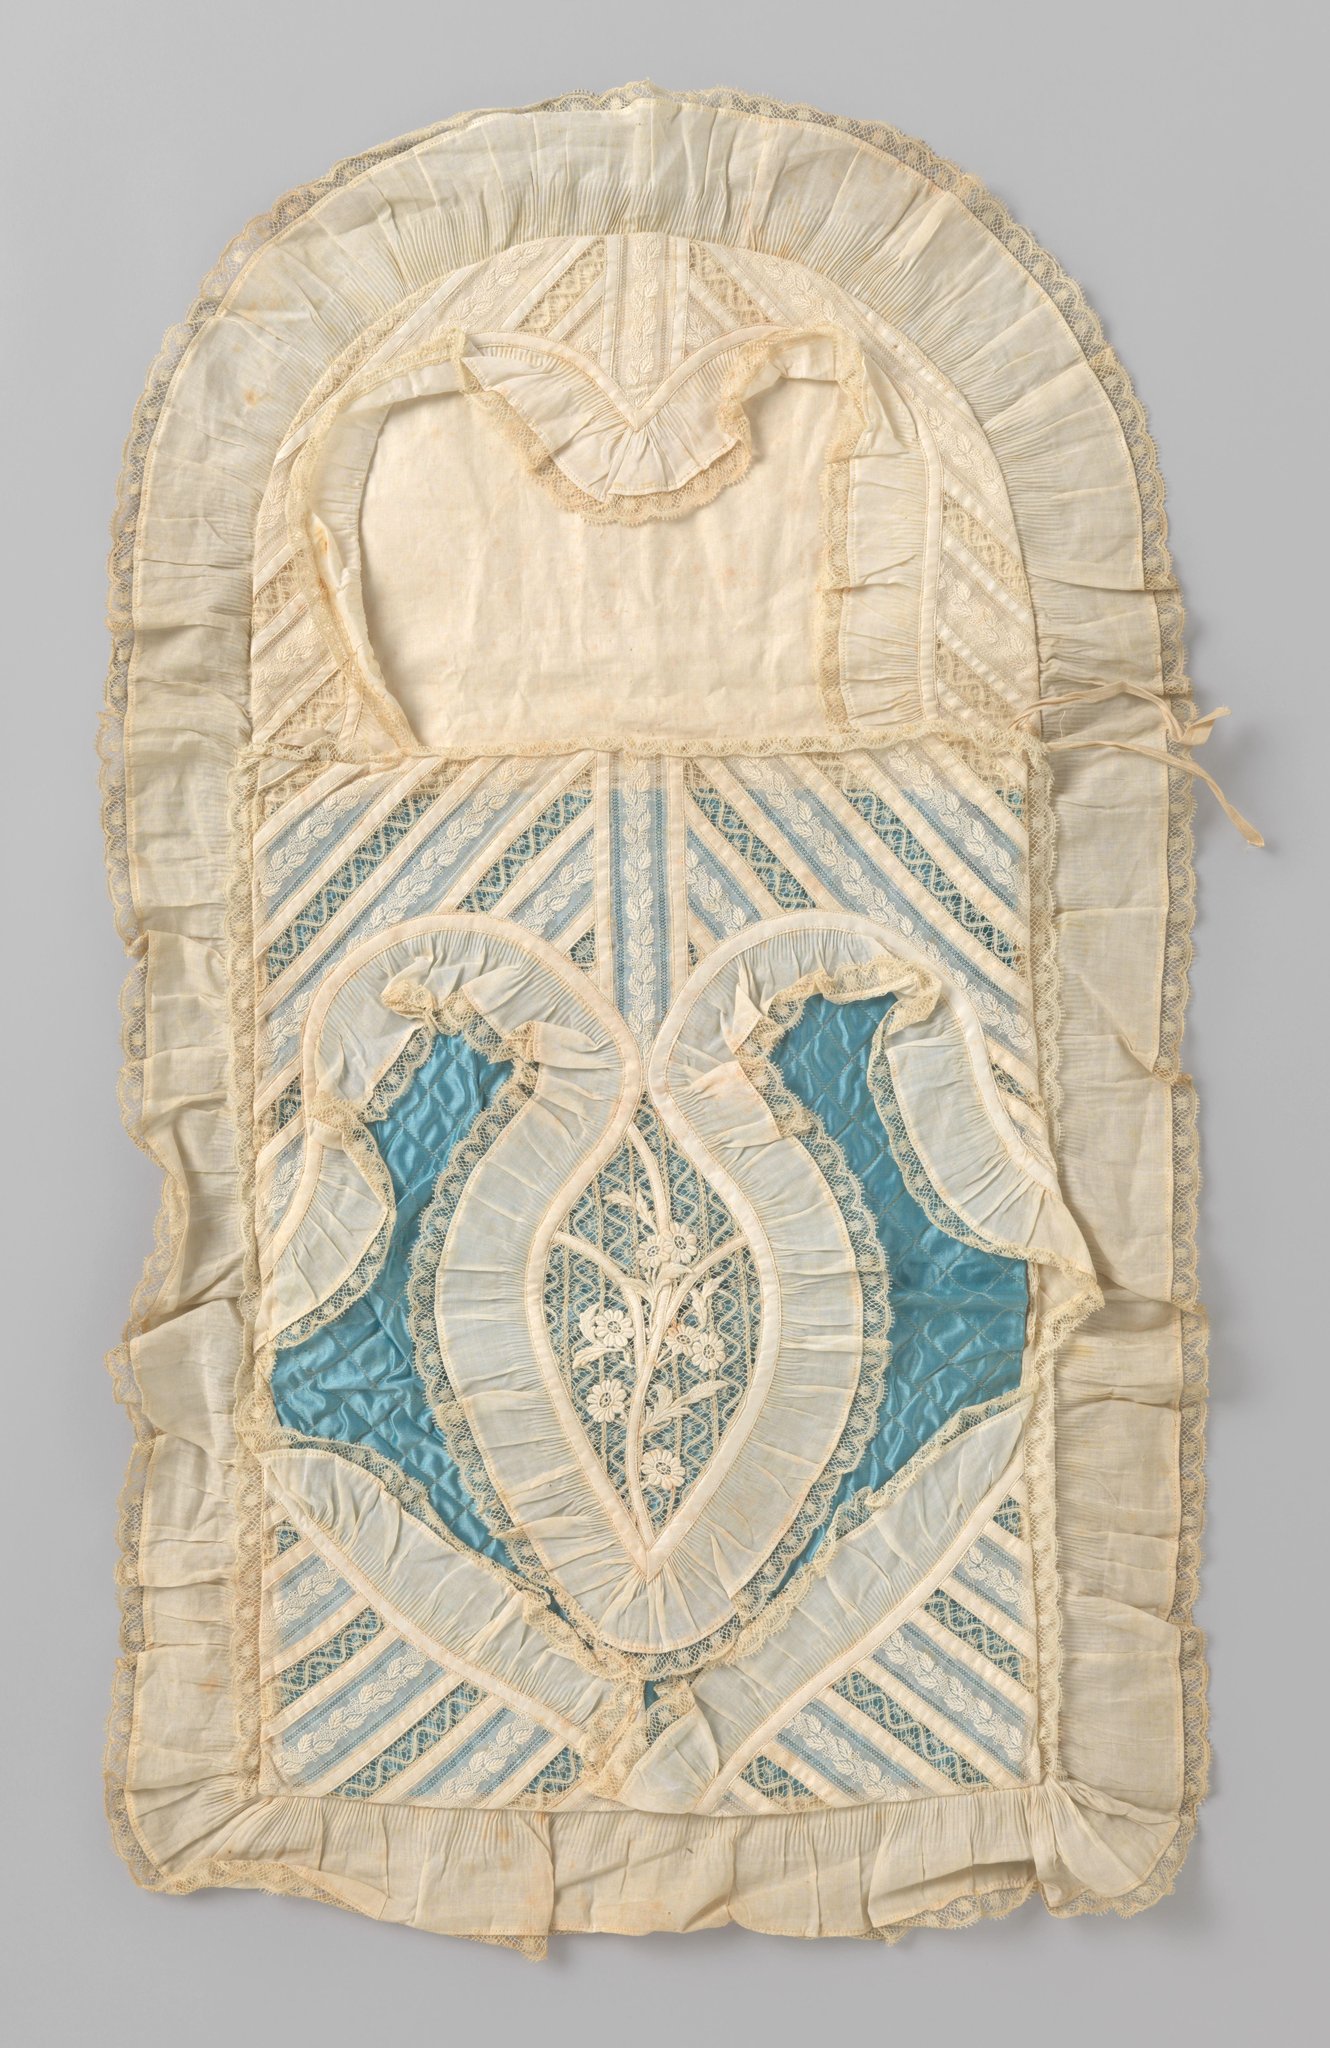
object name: baby wear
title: Draagzak voor baby van witte katoen, satijn, kant en borduurwerk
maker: Anonymous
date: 1880-1890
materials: cotton, textile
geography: netherlands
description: Een draagzak voor een baby "in 't pak", van wit katoen, kant en borduursel en blauw satijn, "Brasserie" of "Lit Portatif".